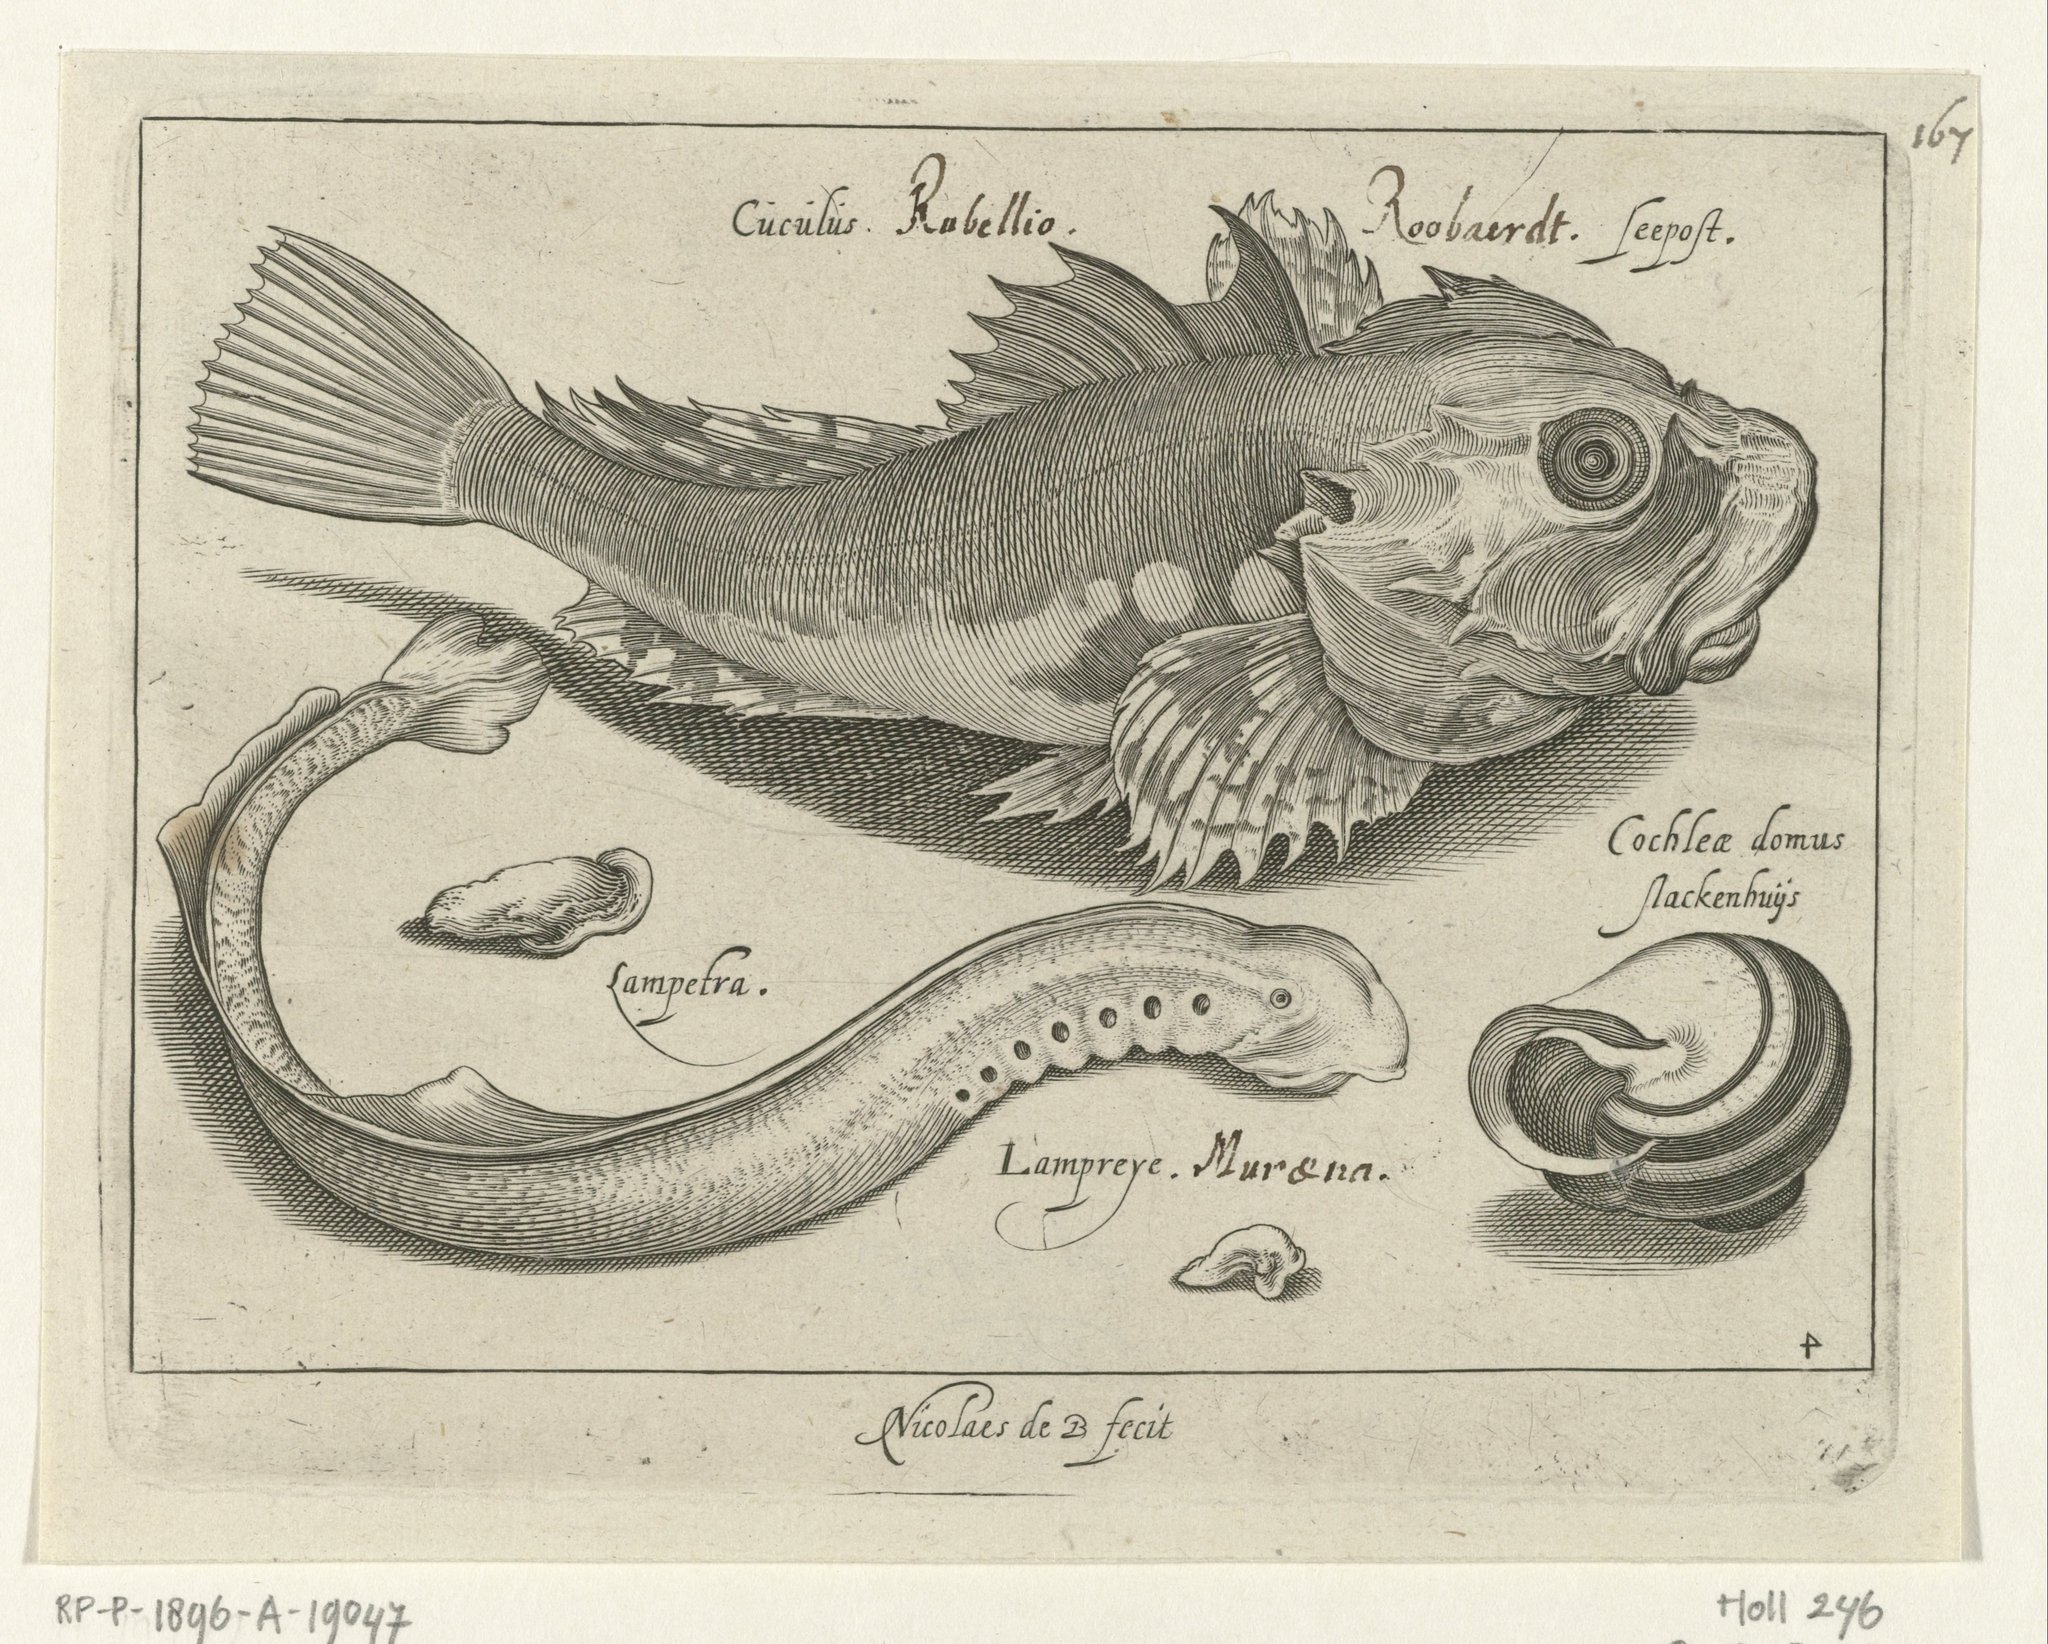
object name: print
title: Libelivs varia Genera piscium complectens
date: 1581-1656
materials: paper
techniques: engraving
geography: netherlands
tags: fishes, animals (+ shell, snail-shell etc.)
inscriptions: collector's mark: Lugt 2228, inscription: ‘Rubellio/ Roobaerdt/ Murona’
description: Prent uit serie Libelivs varia Genera piscium complectens van dertien prenten met zoetwatervissen, zeevissen, kikkers, schaaldieren en zeewezens (inclusief titelprent). Vermoedelijk ging een uitgave van Assuerus van Londerseel vooraf aan deze editie van Francoys van Beusekom, zie De Groot 1988, p. 38.